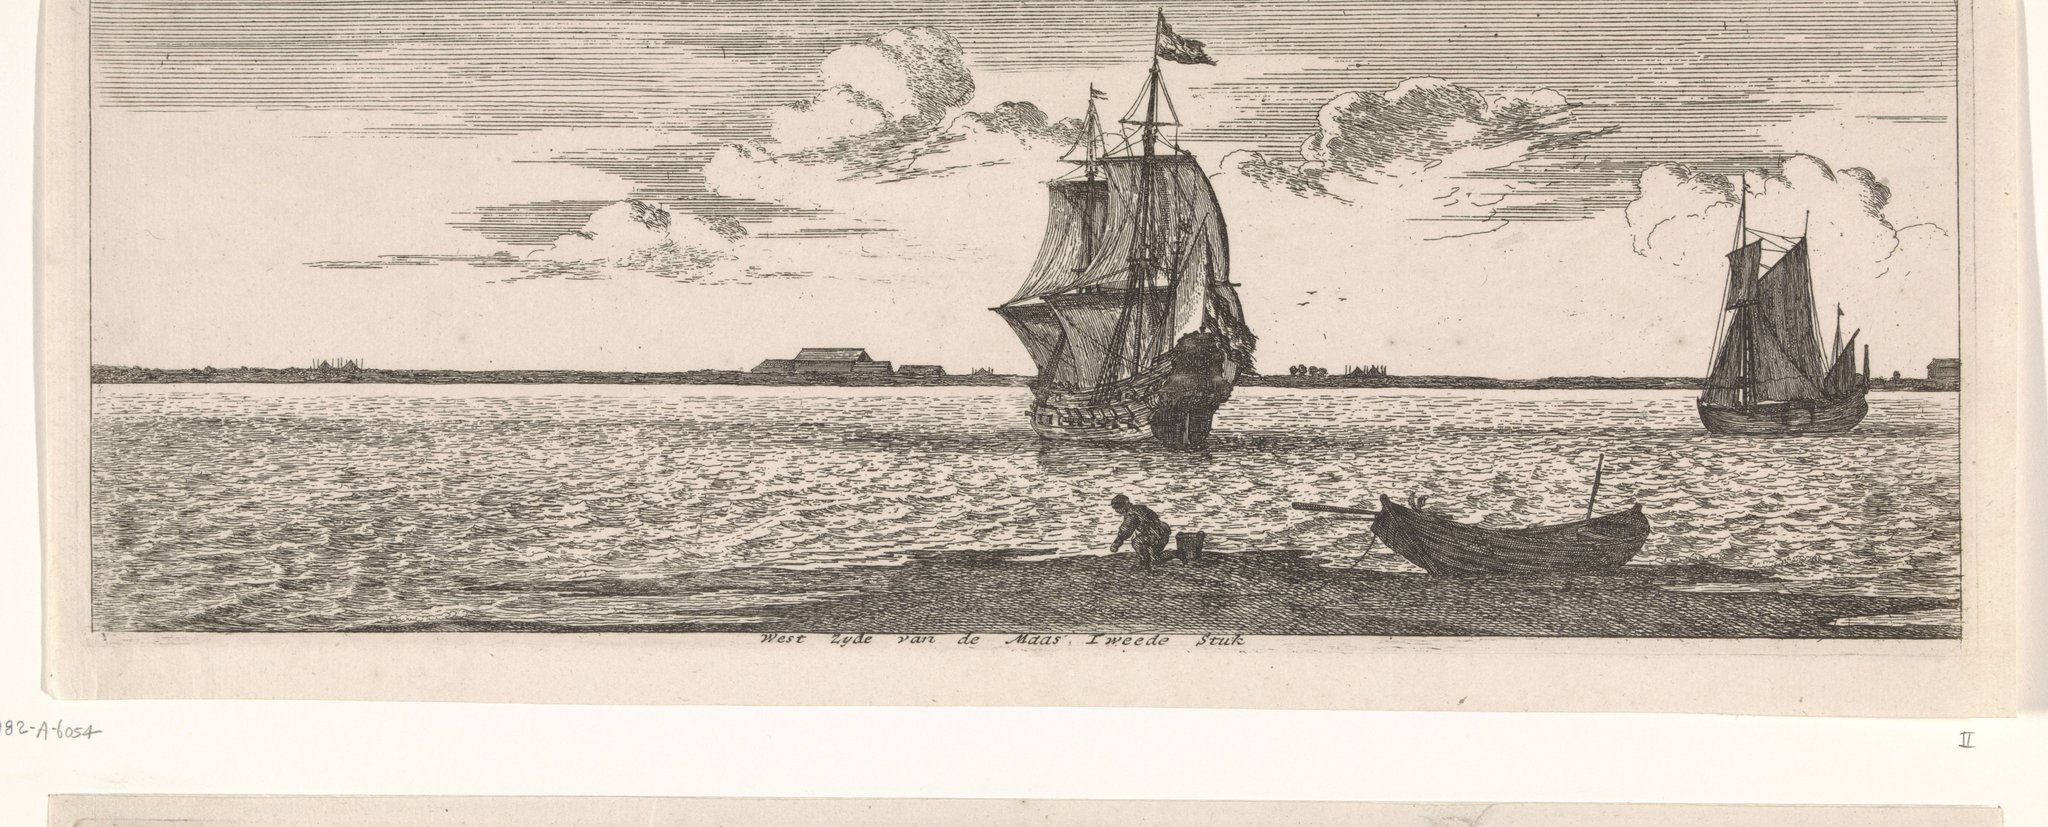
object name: print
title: Gezicht op de Maas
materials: paper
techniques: engraving, etching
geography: rotterdam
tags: river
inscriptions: collector's mark: Lugt 2228